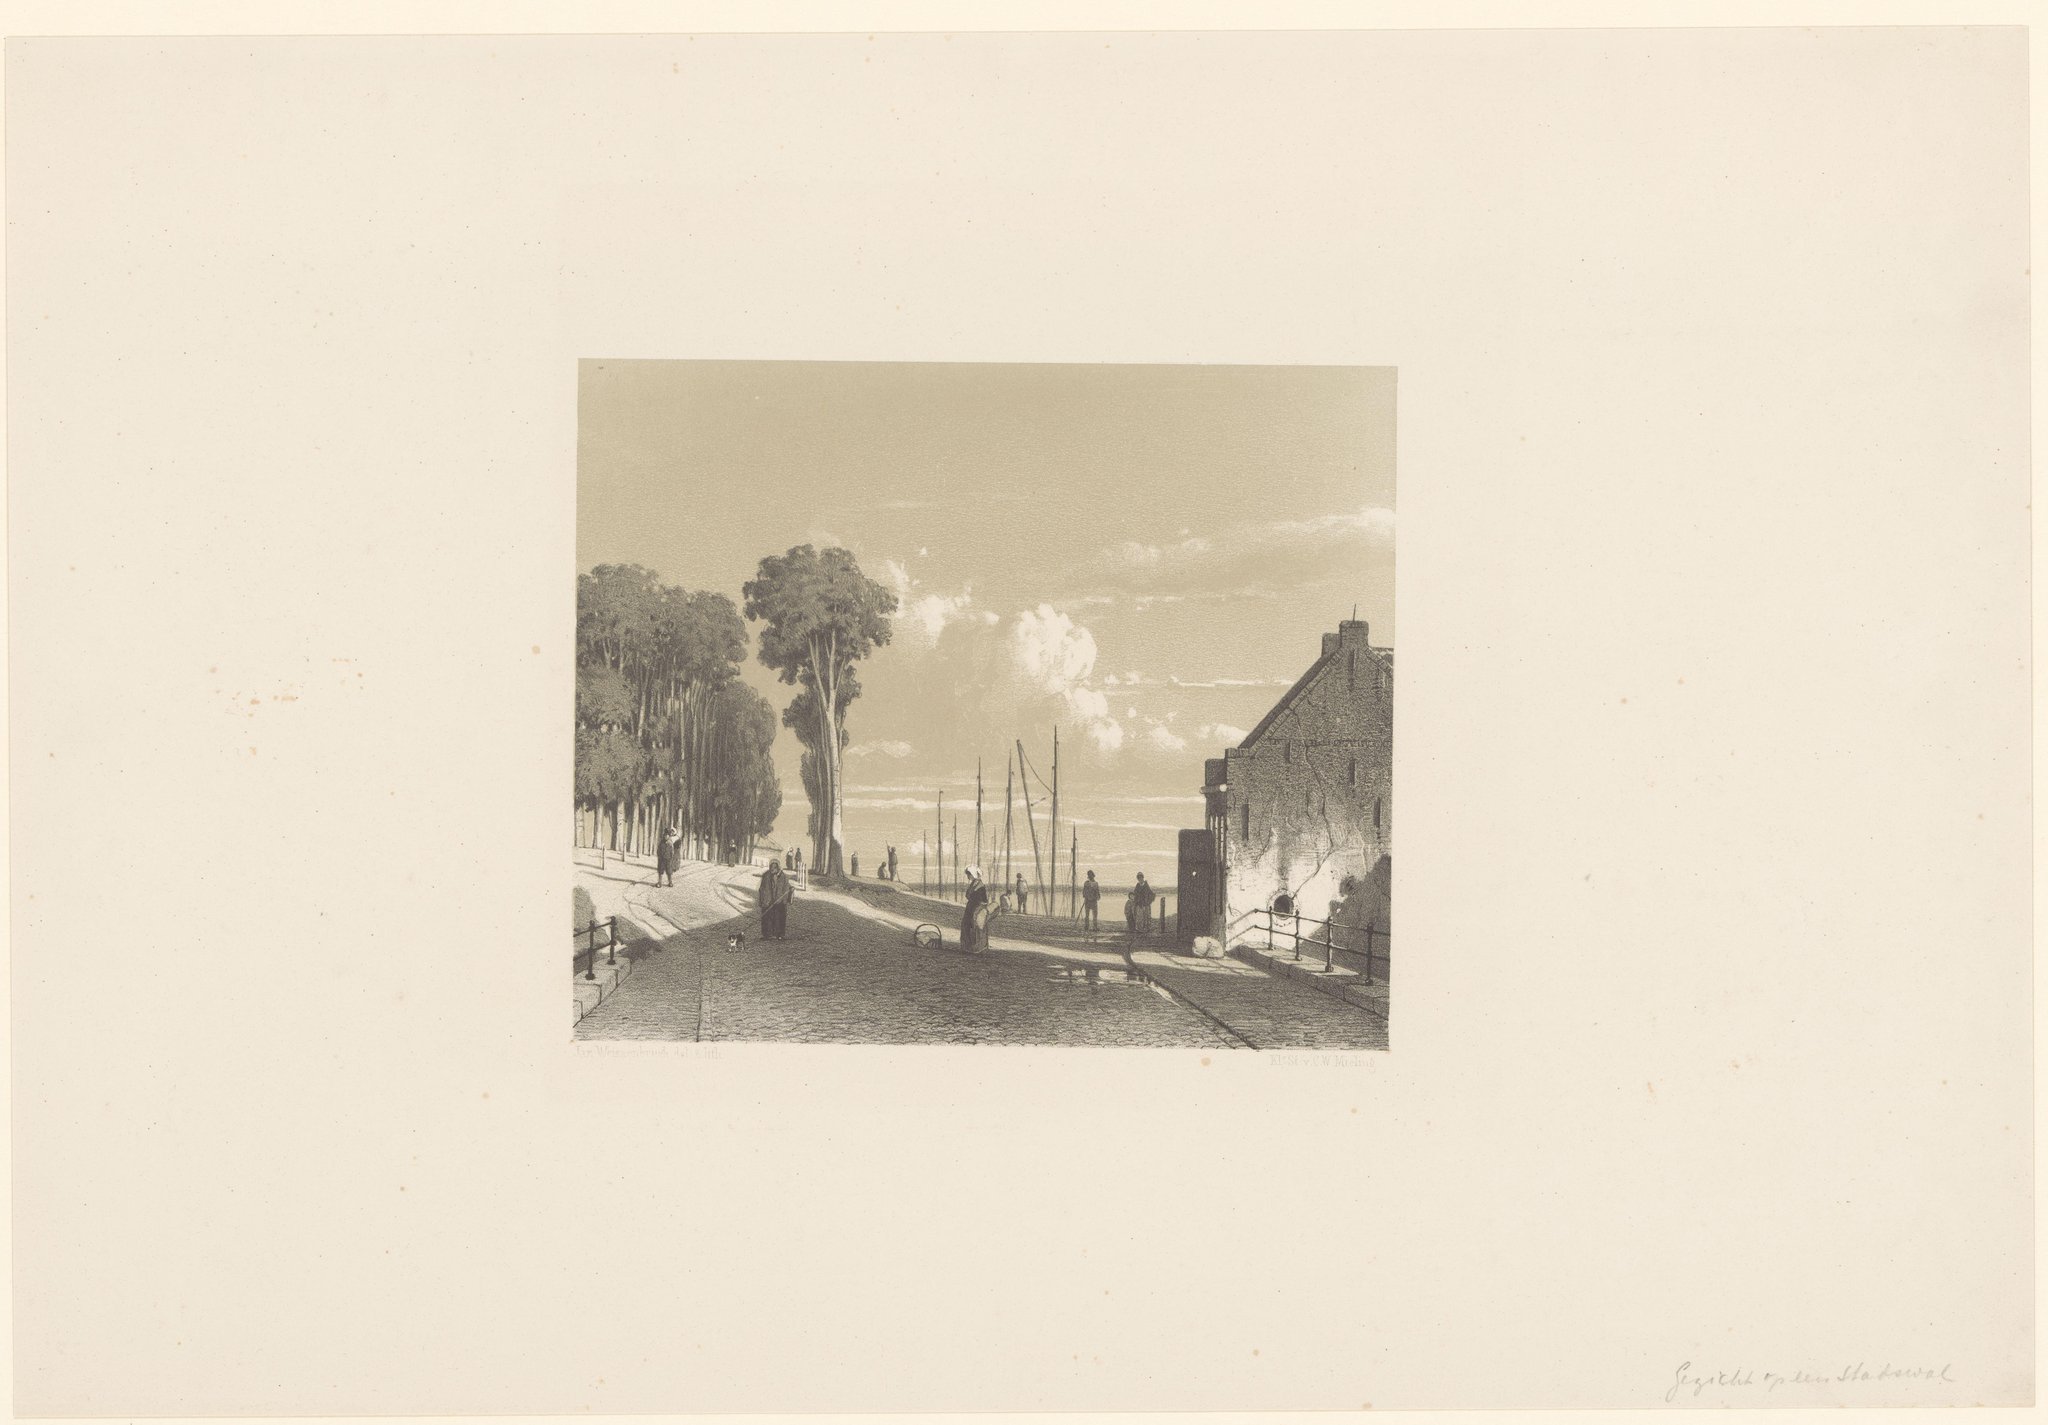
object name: print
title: Gezicht op de Veerweg te Culemborg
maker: jan weissenbruch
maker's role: painter, print maker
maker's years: 1822-1880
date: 1847-1865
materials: paper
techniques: tone lithography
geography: the hague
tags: street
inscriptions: collector's mark: Lugt 2228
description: Mensen lopend op de Veerweg te Culemborg. In de achtergrond masten van zeilboten gelegen in het water.